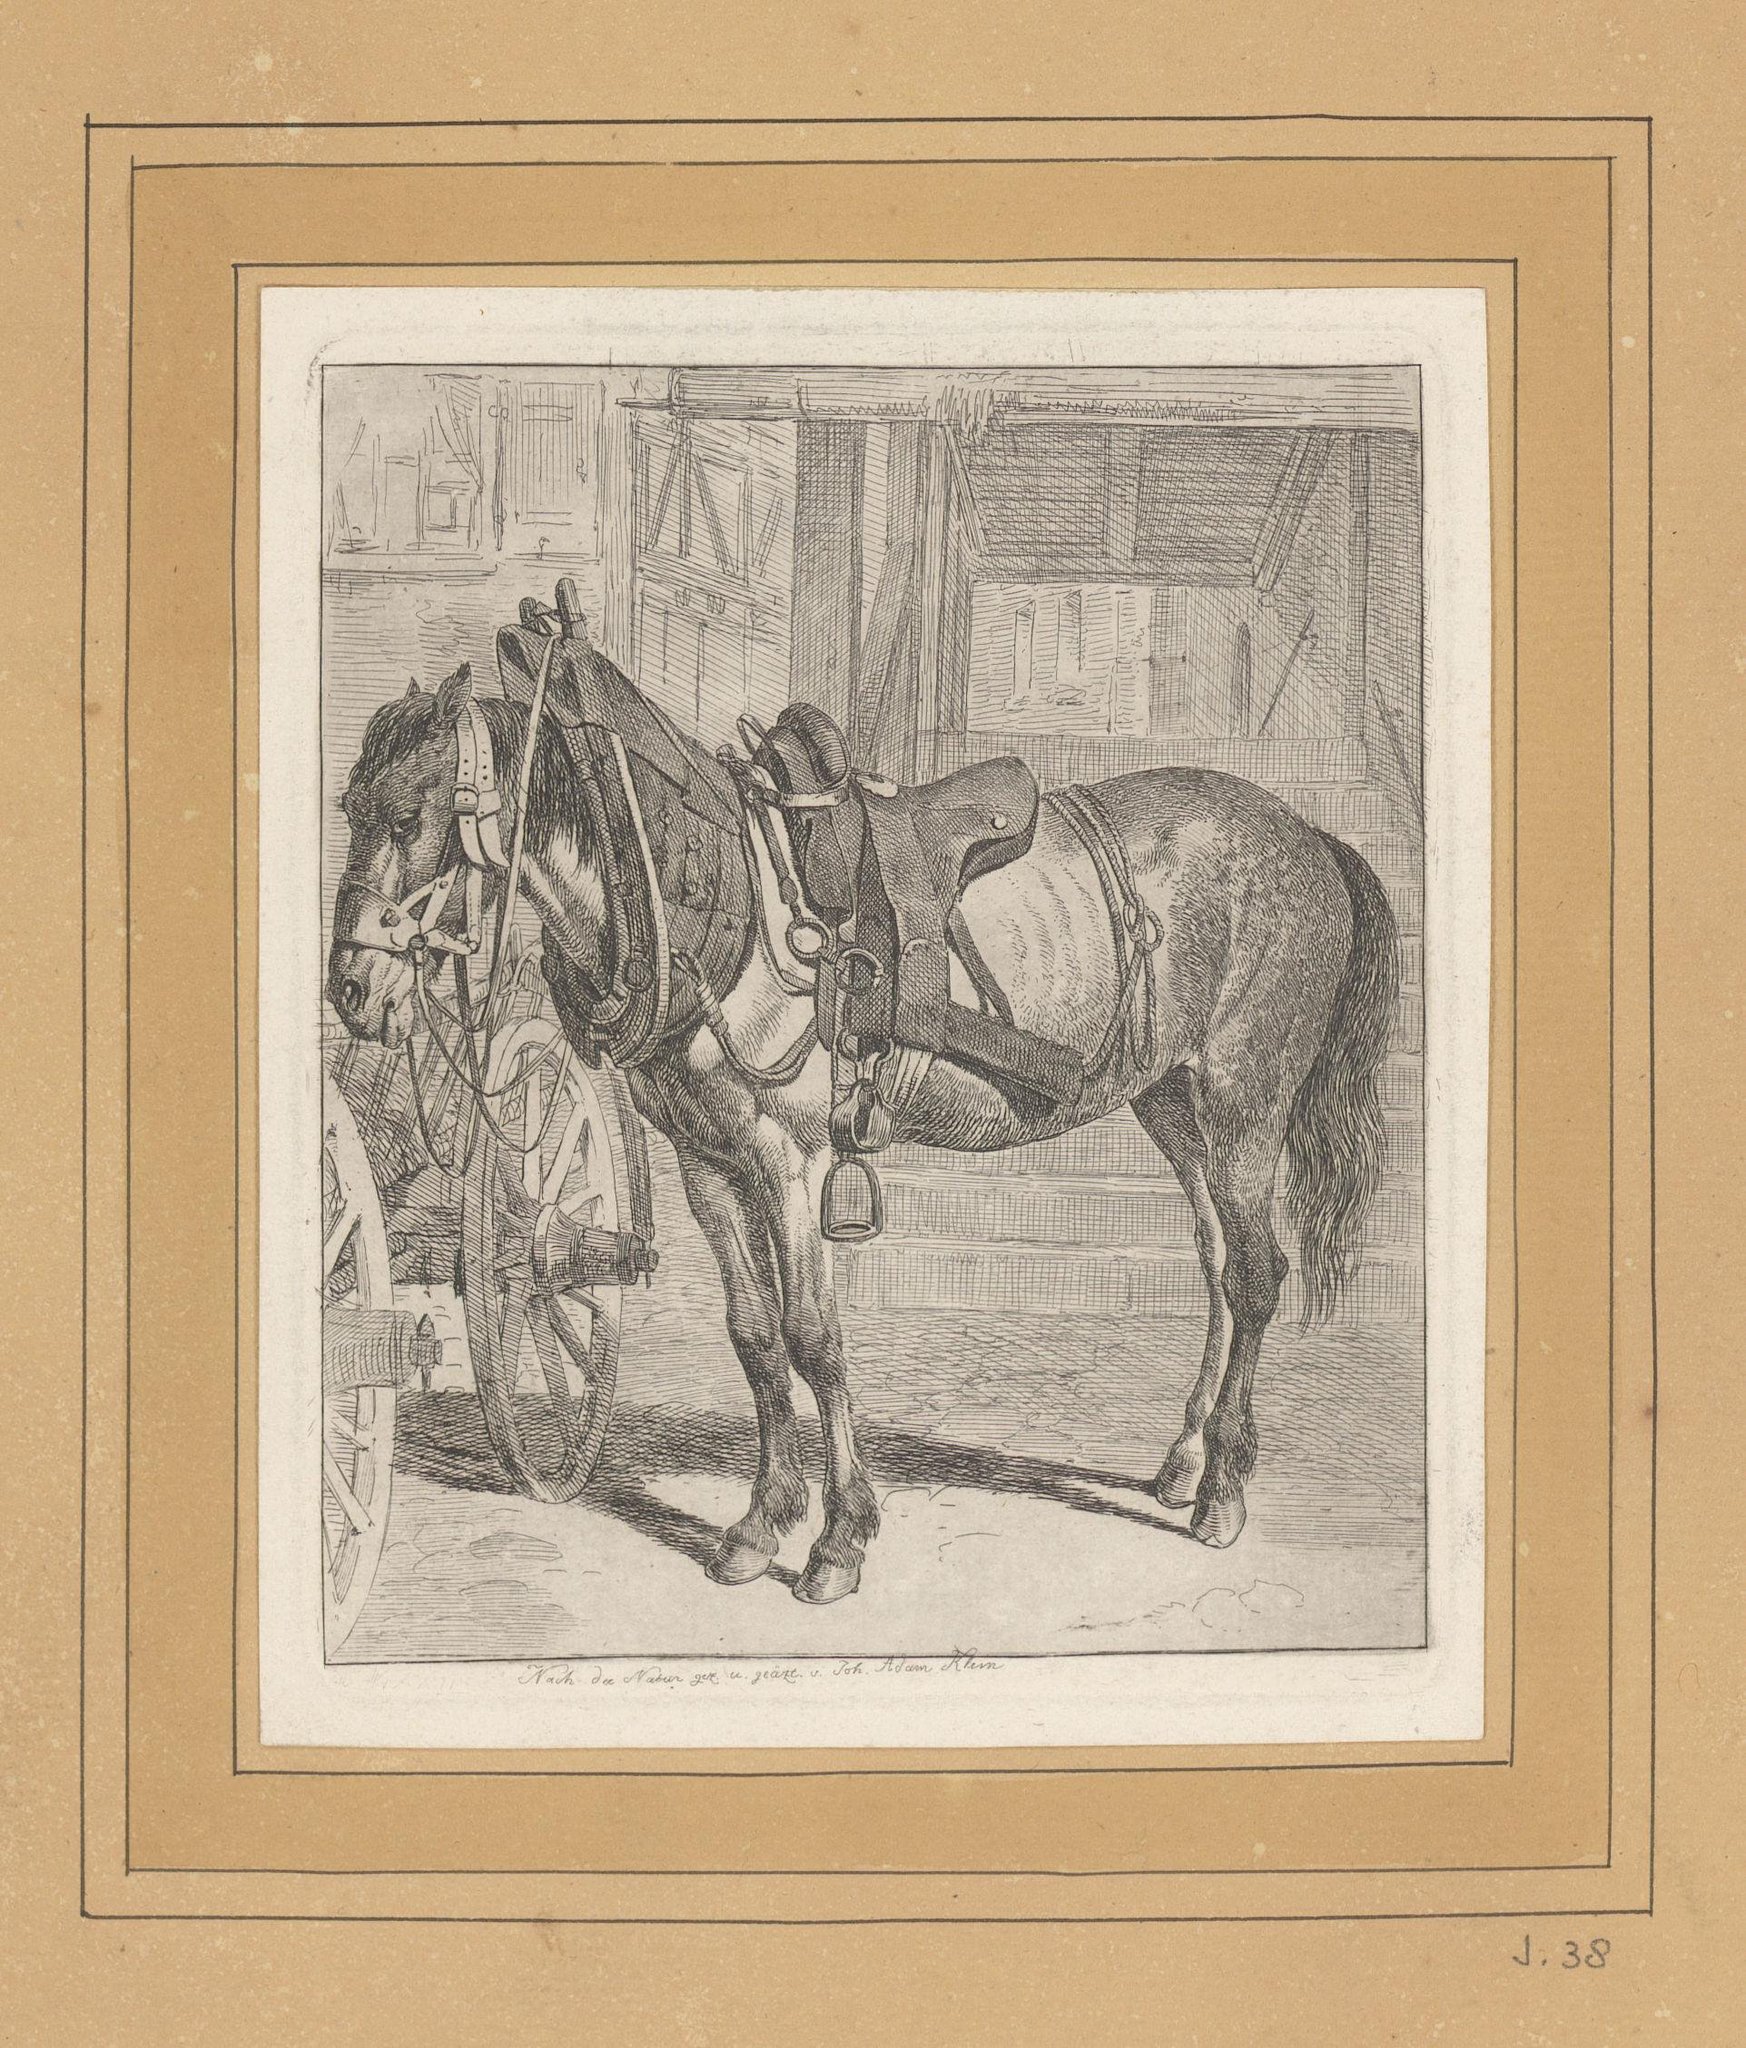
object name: album leaf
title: Trekpaard bij een trap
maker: johann adam klein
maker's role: draughtsman, print maker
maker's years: 1792-1875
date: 1808-1814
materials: paper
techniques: etching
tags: four-wheeled, animal-drawn vehicle, e.g.: cab, carriage, coach, hitching up, harnessing ~ animal traction, horse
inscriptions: collector's mark: Lugt 2228, collector's mark: Lugt 2760